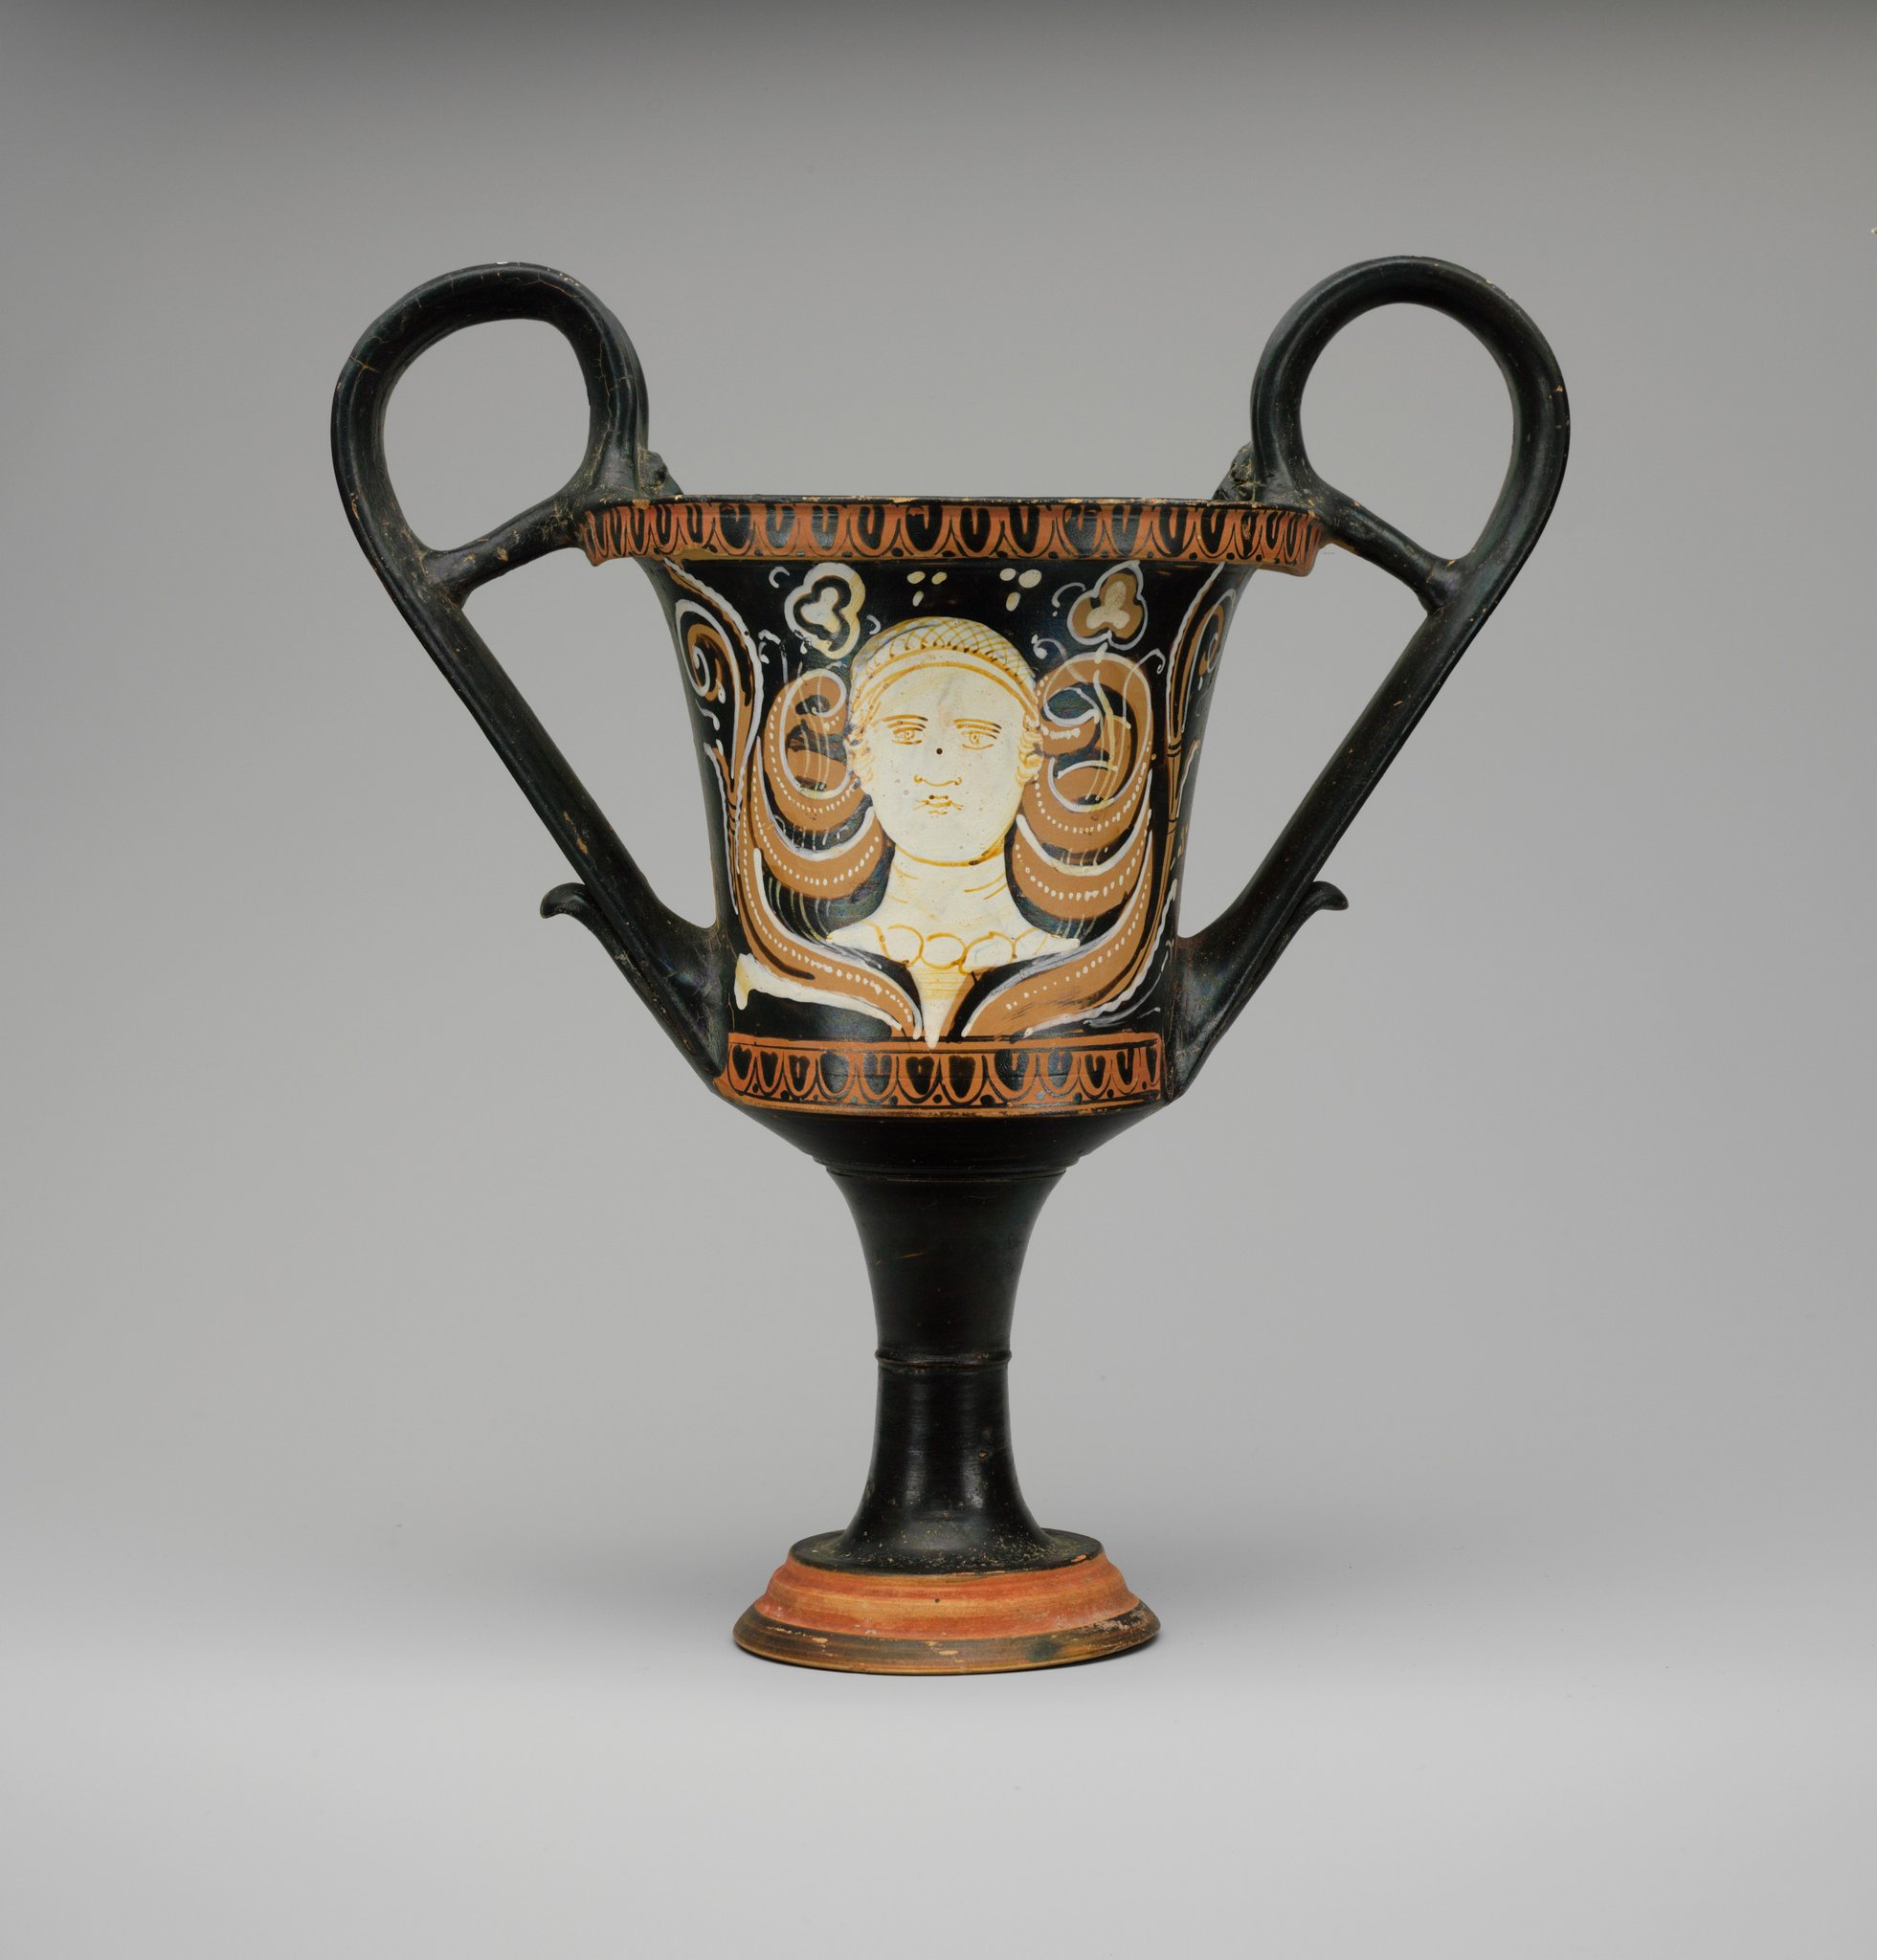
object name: kantharos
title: Terracotta kantharos (drinking cup with high handles)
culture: greek, south italian, apulian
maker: painter of bari 5981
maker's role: artist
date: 325-300 BCE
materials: terracotta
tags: heads,women